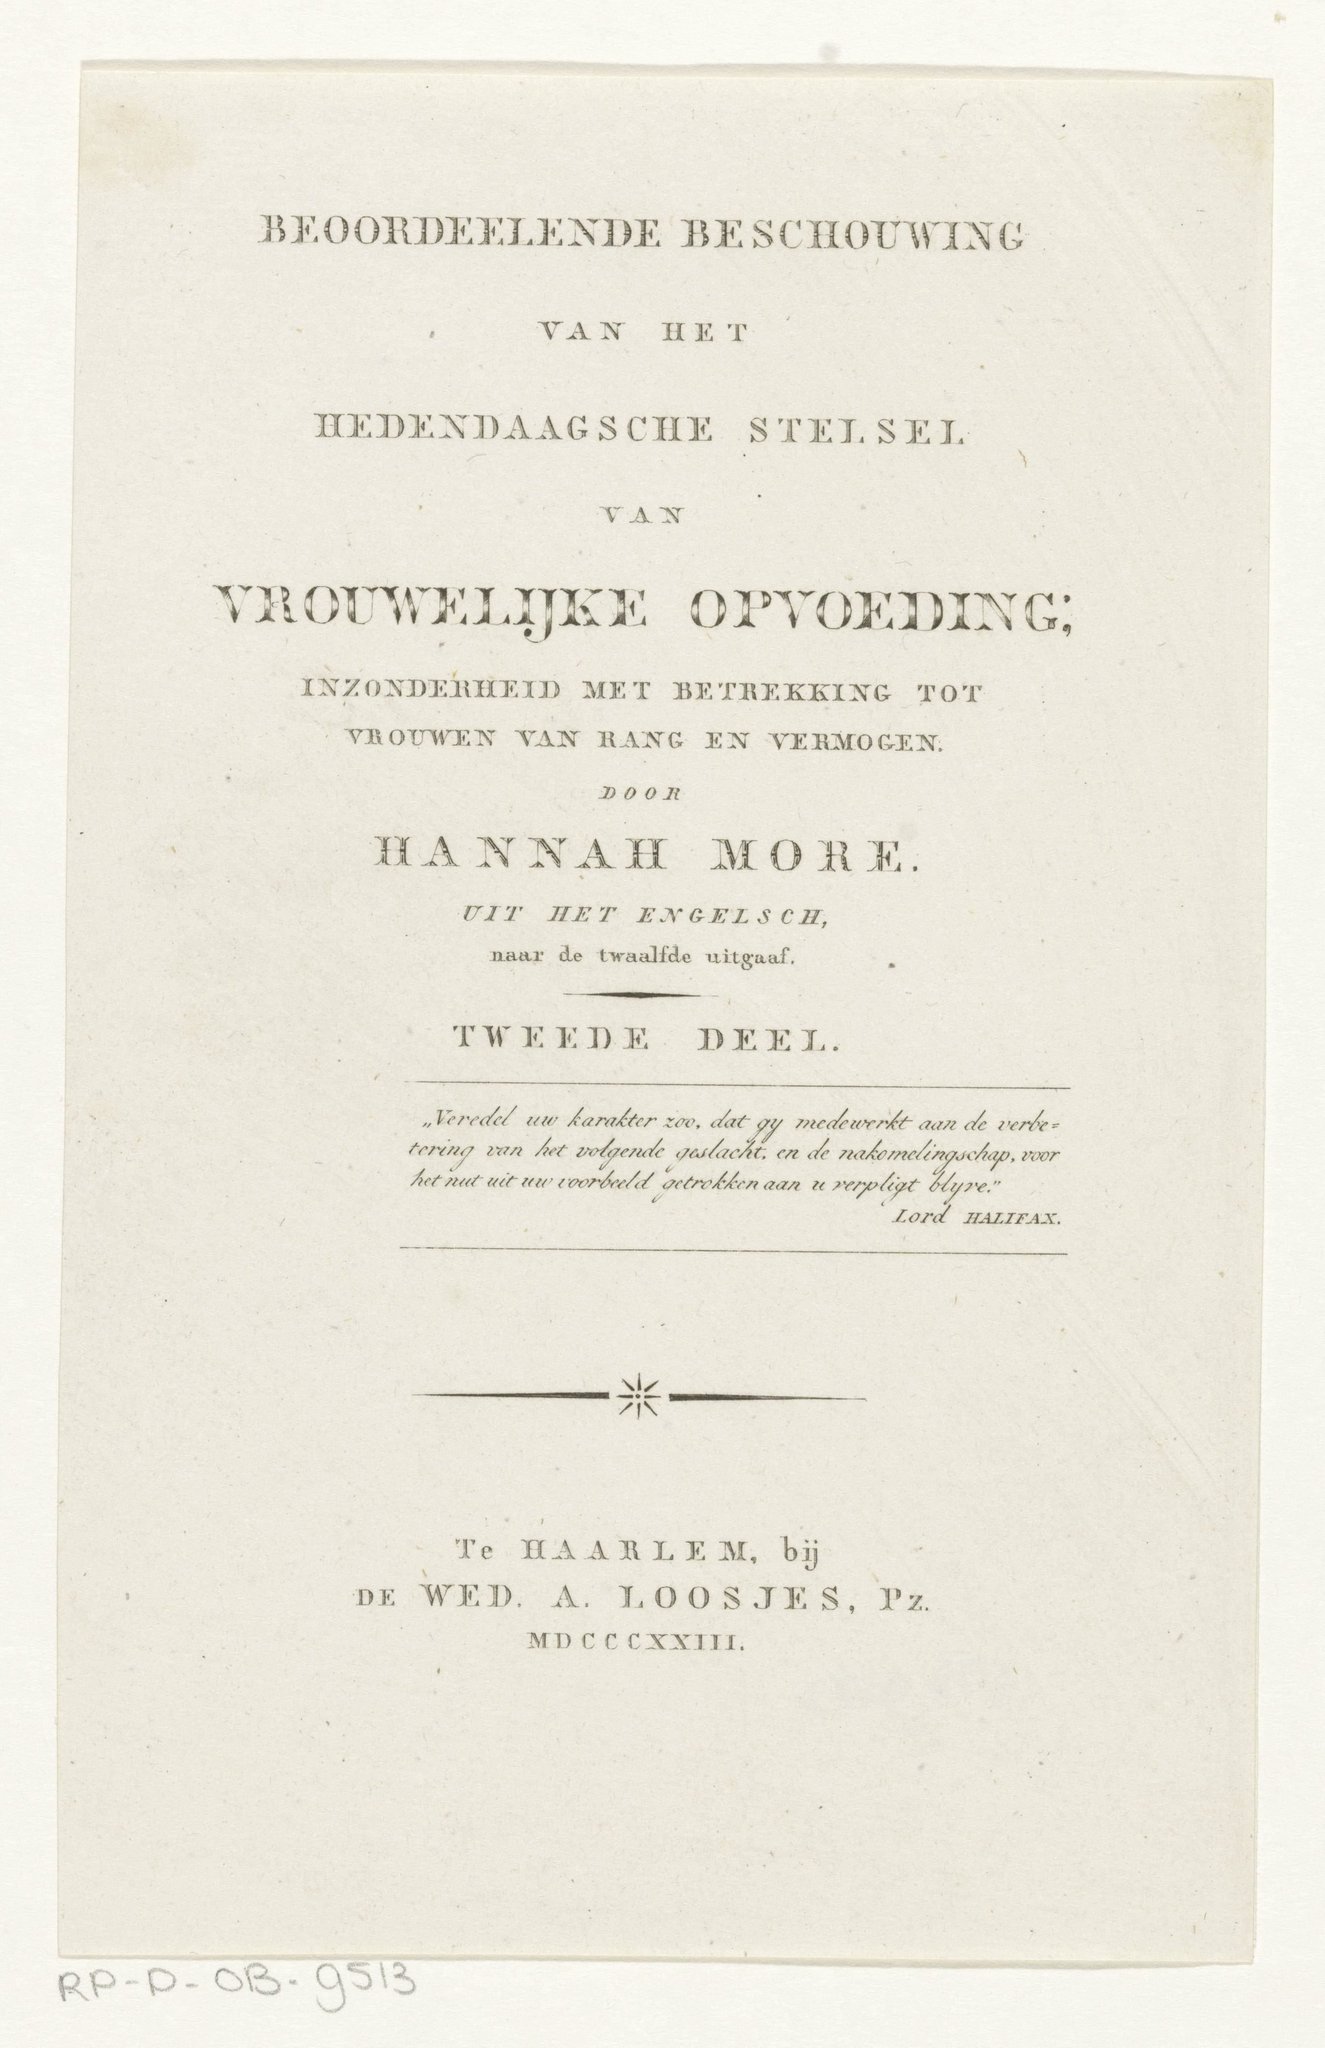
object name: print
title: Titelpagina voor: Hannah More, Beoordeelende beschouwing van het hedendaagsche stelsel van vrouwelijke opvoeding, 1823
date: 1823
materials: paper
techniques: engraving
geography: haarlem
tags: title-page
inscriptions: collector's mark: Lugt 2228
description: Titelpagina voor: More, Hannah. Beoordeelende beschouwing van het hedendaagsche stelsel van vrouwelijke opvoeding (...) tweede deel. Haarlem: Loosjes Pz., weduwe Adriaan, 1823.